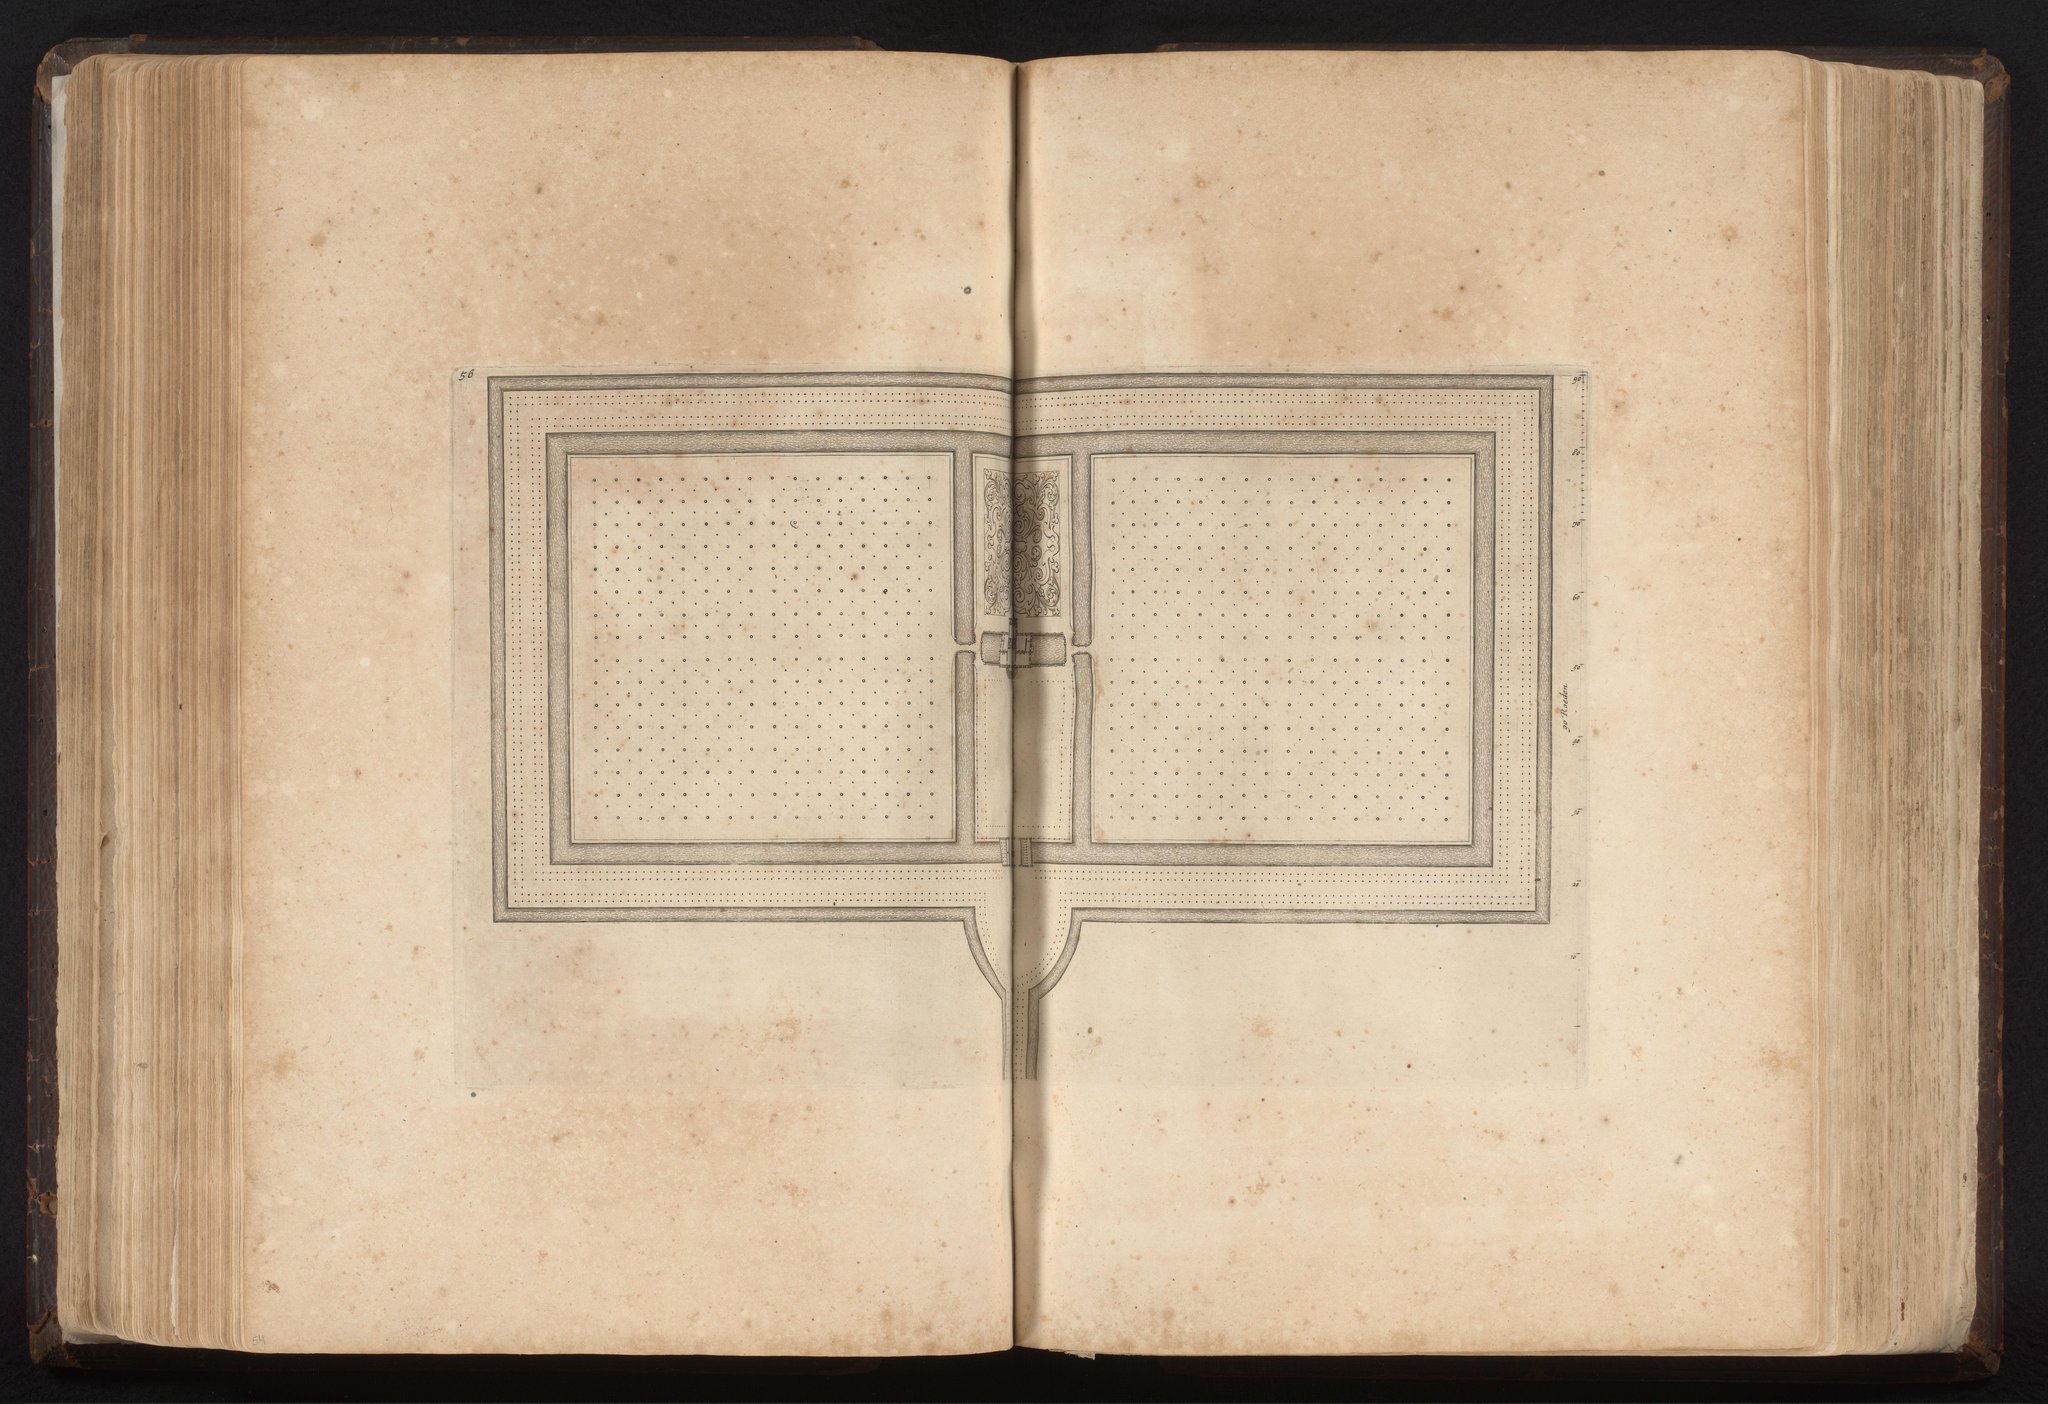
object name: book illustration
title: Plattegrond voor een tuin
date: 1648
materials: paper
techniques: engraving, etching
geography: amsterdam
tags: plan, map of garden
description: Prent uit: Afbeelsels der voornaemste gebouwen uyt alle die Philips Vingboons geordineert heeft. Amsterdam: Philips en Johannes Vinckboons en Johannes Willemszoon Blaeu, 1648.